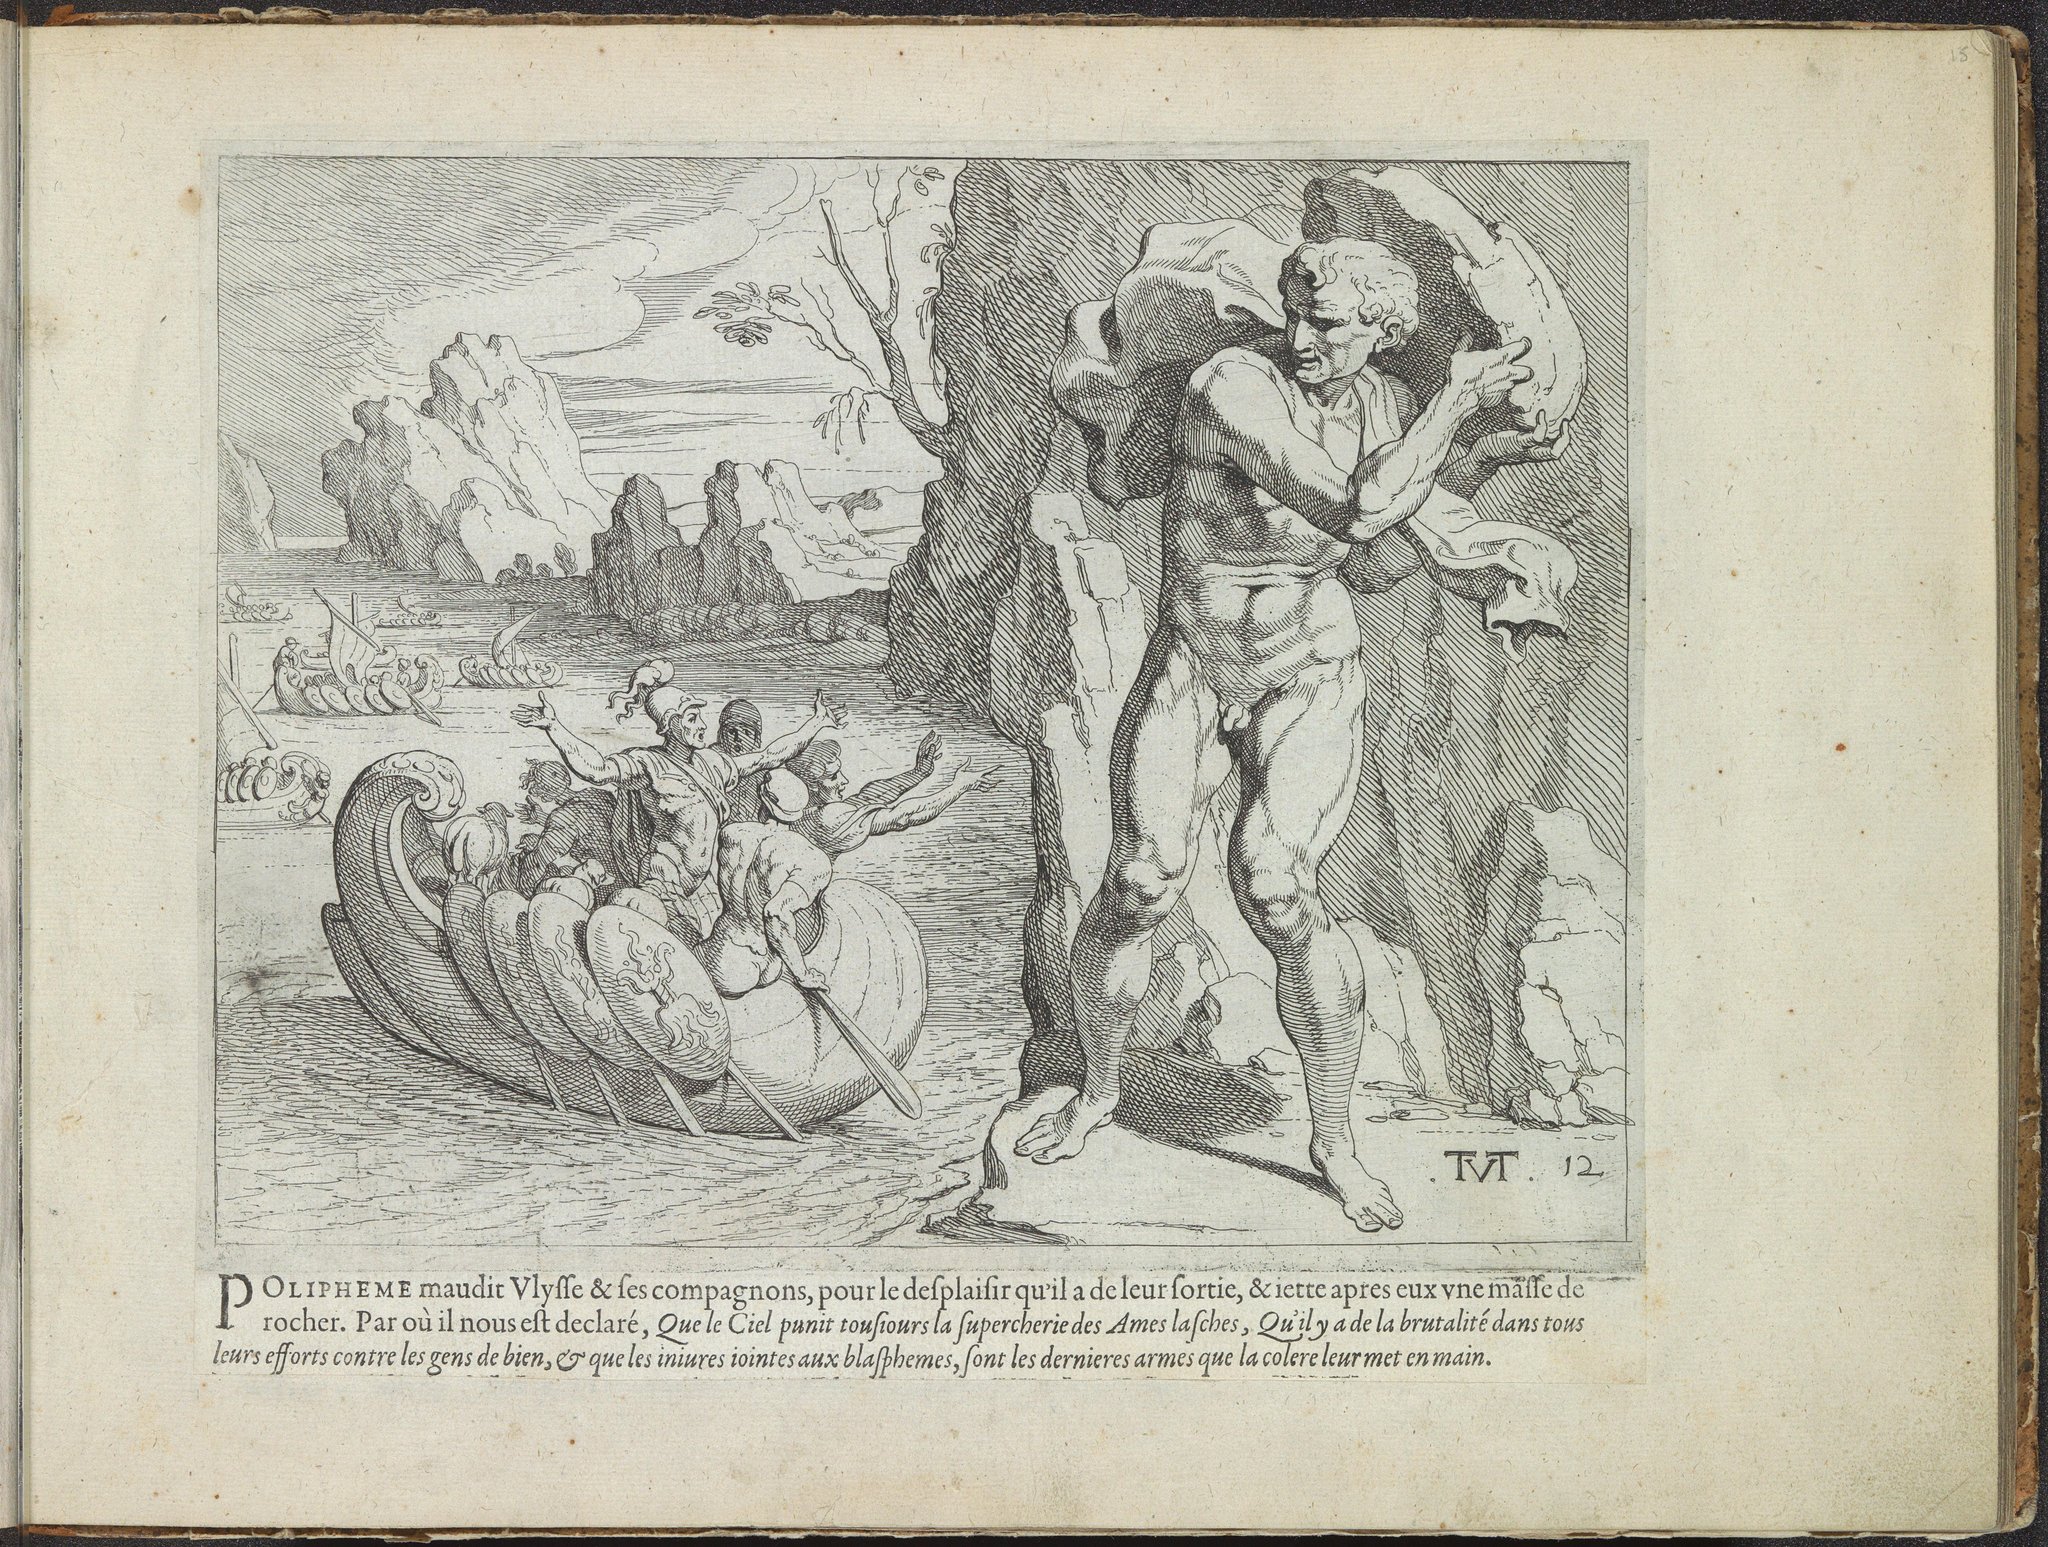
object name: album leaf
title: Les Travaux d'Ulysse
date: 1633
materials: paper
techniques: engraving, etching, letterpress printing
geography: paris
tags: polyphemus hurls a rock at ulysses' departing ships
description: De reus Polyphemus werpt een rots naar het vertrekkende schip van Odysseus. De prent maakt deel uit van een album.